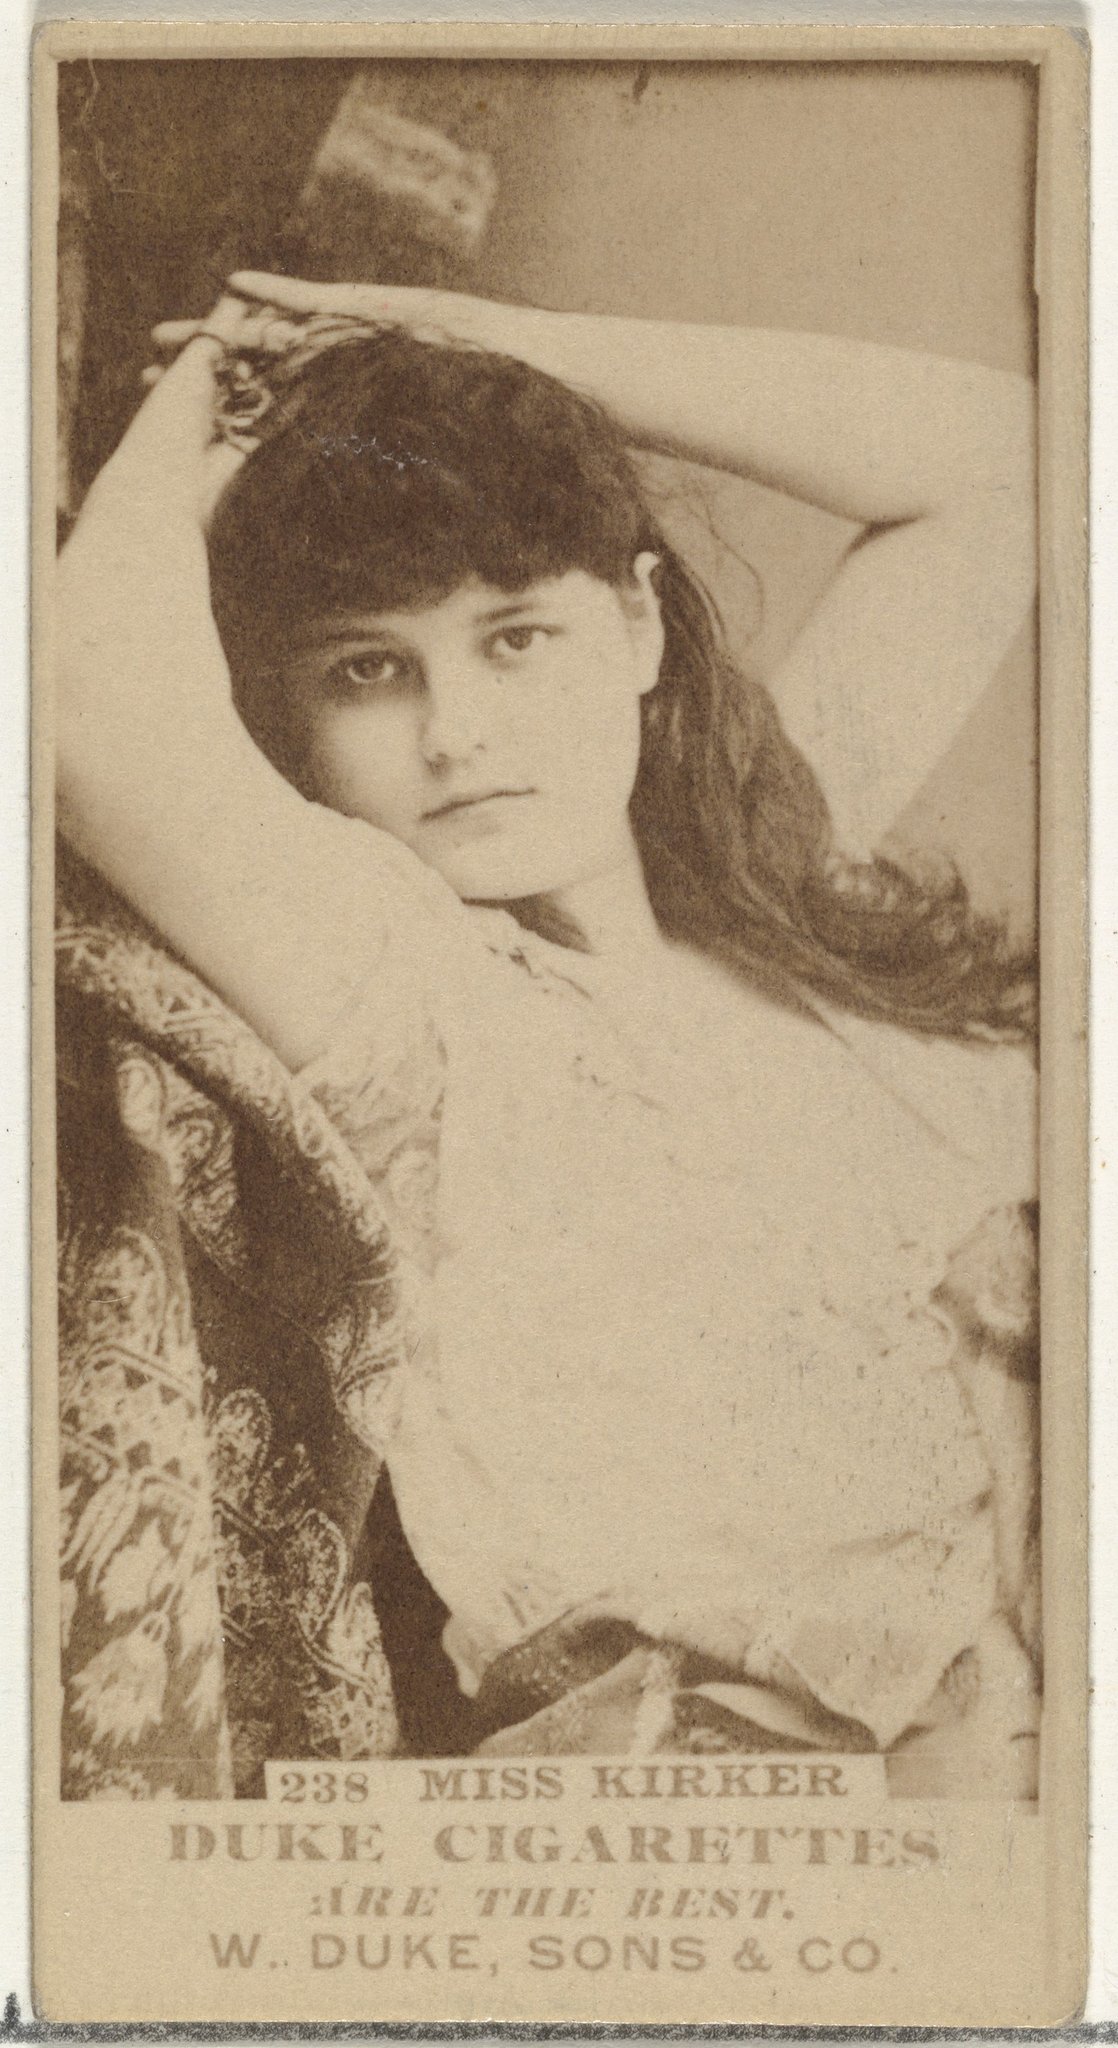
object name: photograph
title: Card Number 238, Miss Kirker, from the Actors and Actresses series (N145-7) issued by Duke Sons & Co. to promote Duke Cigarettes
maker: w. duke, sons & co.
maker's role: publisher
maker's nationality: american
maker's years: 1870-1920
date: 1880-1889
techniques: albumen silver print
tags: portraits,women,actresses